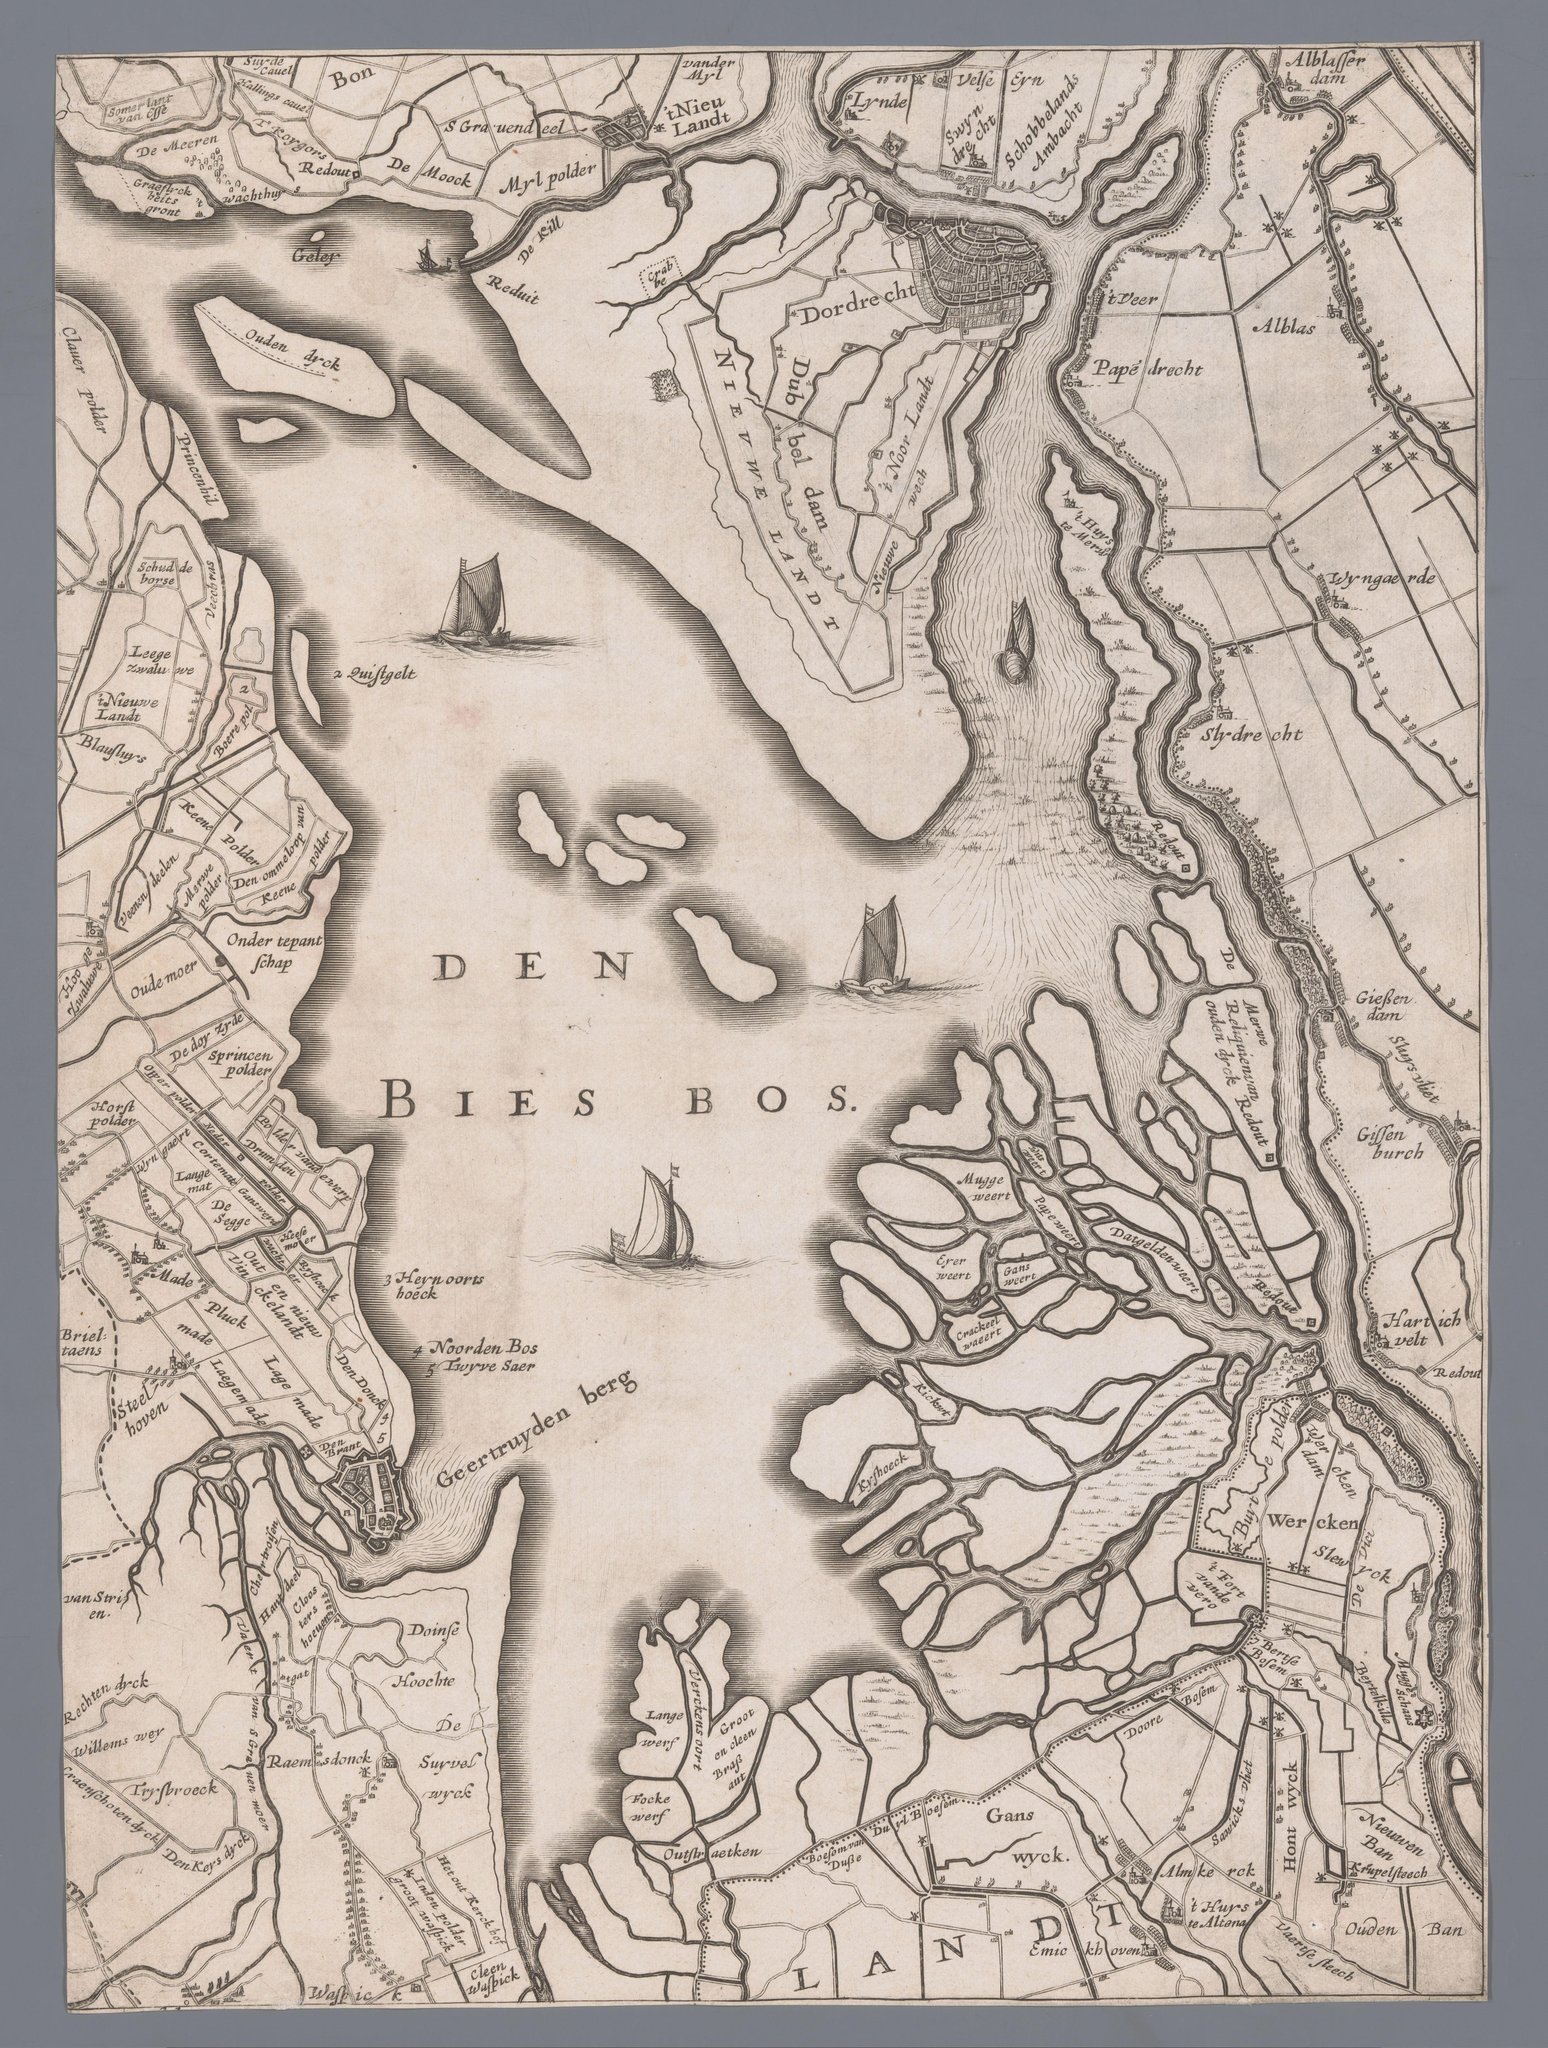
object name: print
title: Kaart van het Graafschap Holland en Utrecht (plaat 29)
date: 1639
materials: paper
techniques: engraving, etching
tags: sailing-ship, sailing-boat, maps, atlases, dordrecht, geertruidenberg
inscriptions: collector's mark: Lugt 2228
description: Onderdeel van een kaart samengesteld uit 40 bladen. Waarschijnlijk gaat het om de grootste kaart van Holland uit de zeventiende-eeuw. De kaart is uitgegeven in verschillende edities, deze kaart uit 1639 is de eerste editie.